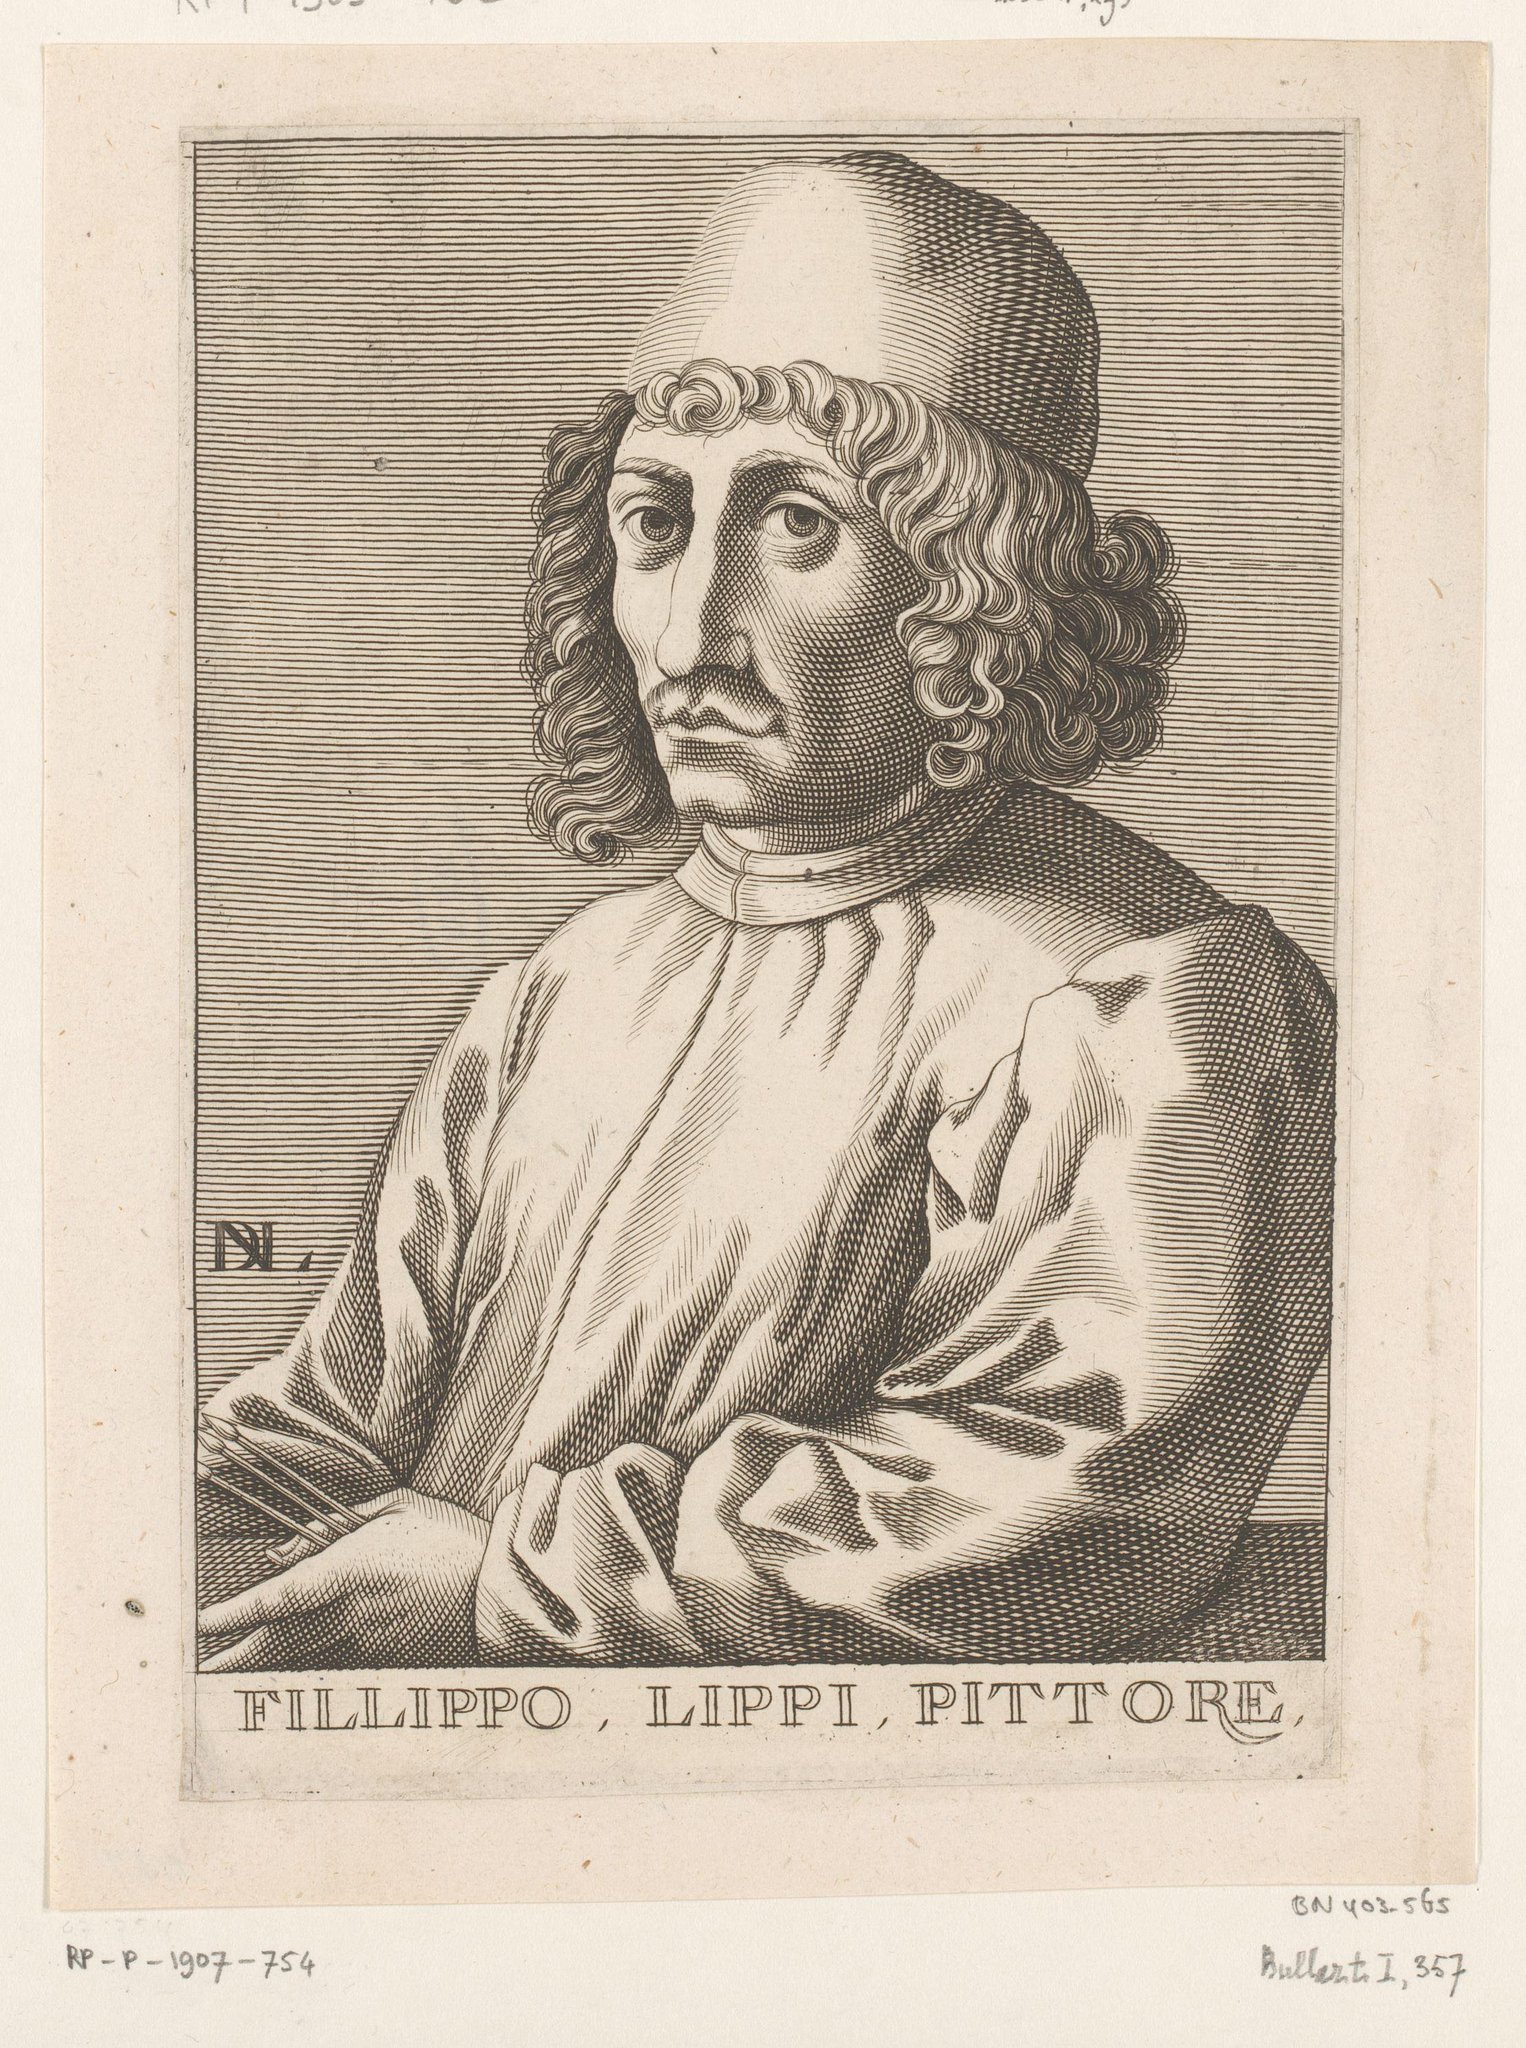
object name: book illustration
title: Portret van Filippo Lippi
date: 1682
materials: paper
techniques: engraving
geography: brussels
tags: painter, filippo lippi, historical persons, portrait, self-portrait of artist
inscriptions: collector's mark: Lugt 2228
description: Prent gebruikt voor: Bullart, Isaac. Académie des Sciences et Arts contenant les vies et éloges his. des hommes illustres qui ont excellé en ces professions depuis environ quatre siècles. Brussel: François Foppens, 1682. Het boek werd in 1682 eveneens in Amsterdam uitgegeven door de erfgenamen van Daniel Elzevier. Ieder portret betreft een illustratie bij de biografie van een kunstenaar of geleerde. De meeste portretten werden door Nicolas de Larmessin vervaardigd (162), 93 door De Boulonois en een derde door ongeïdentificeerde prentmakers. Dit betreft een illustratie op p. 357, deel I.